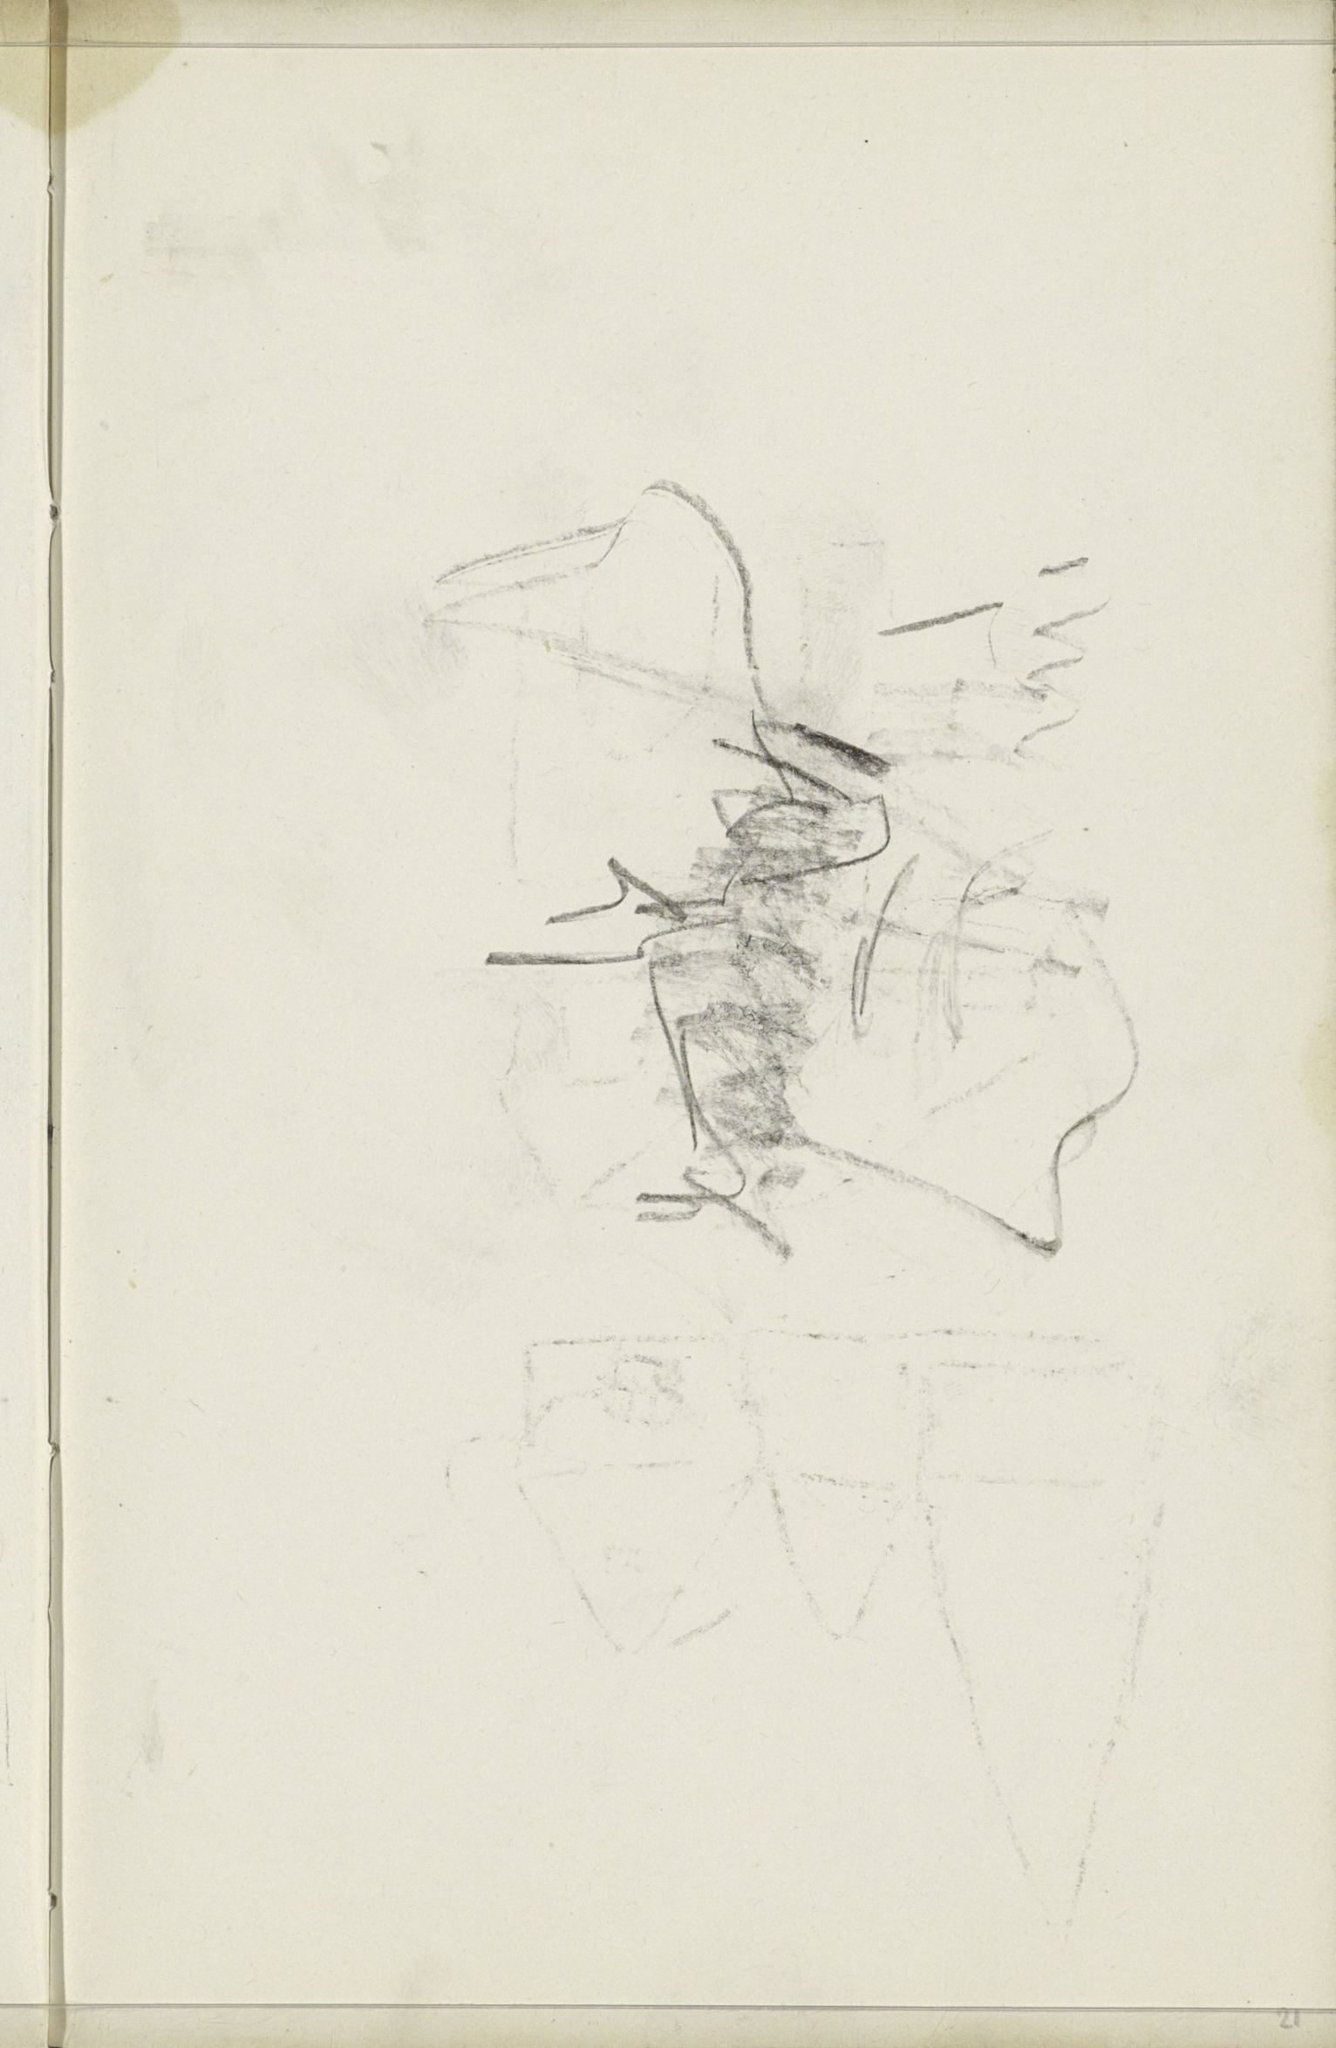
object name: sketchbook leaf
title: Studie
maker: isaac israels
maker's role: draughtsman, painter, print maker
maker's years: 1865-1934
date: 1875-1934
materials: chalk, paper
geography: london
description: Pagina 21 en pagina 22 uit schetsboek XXXV met 36 pagina's.